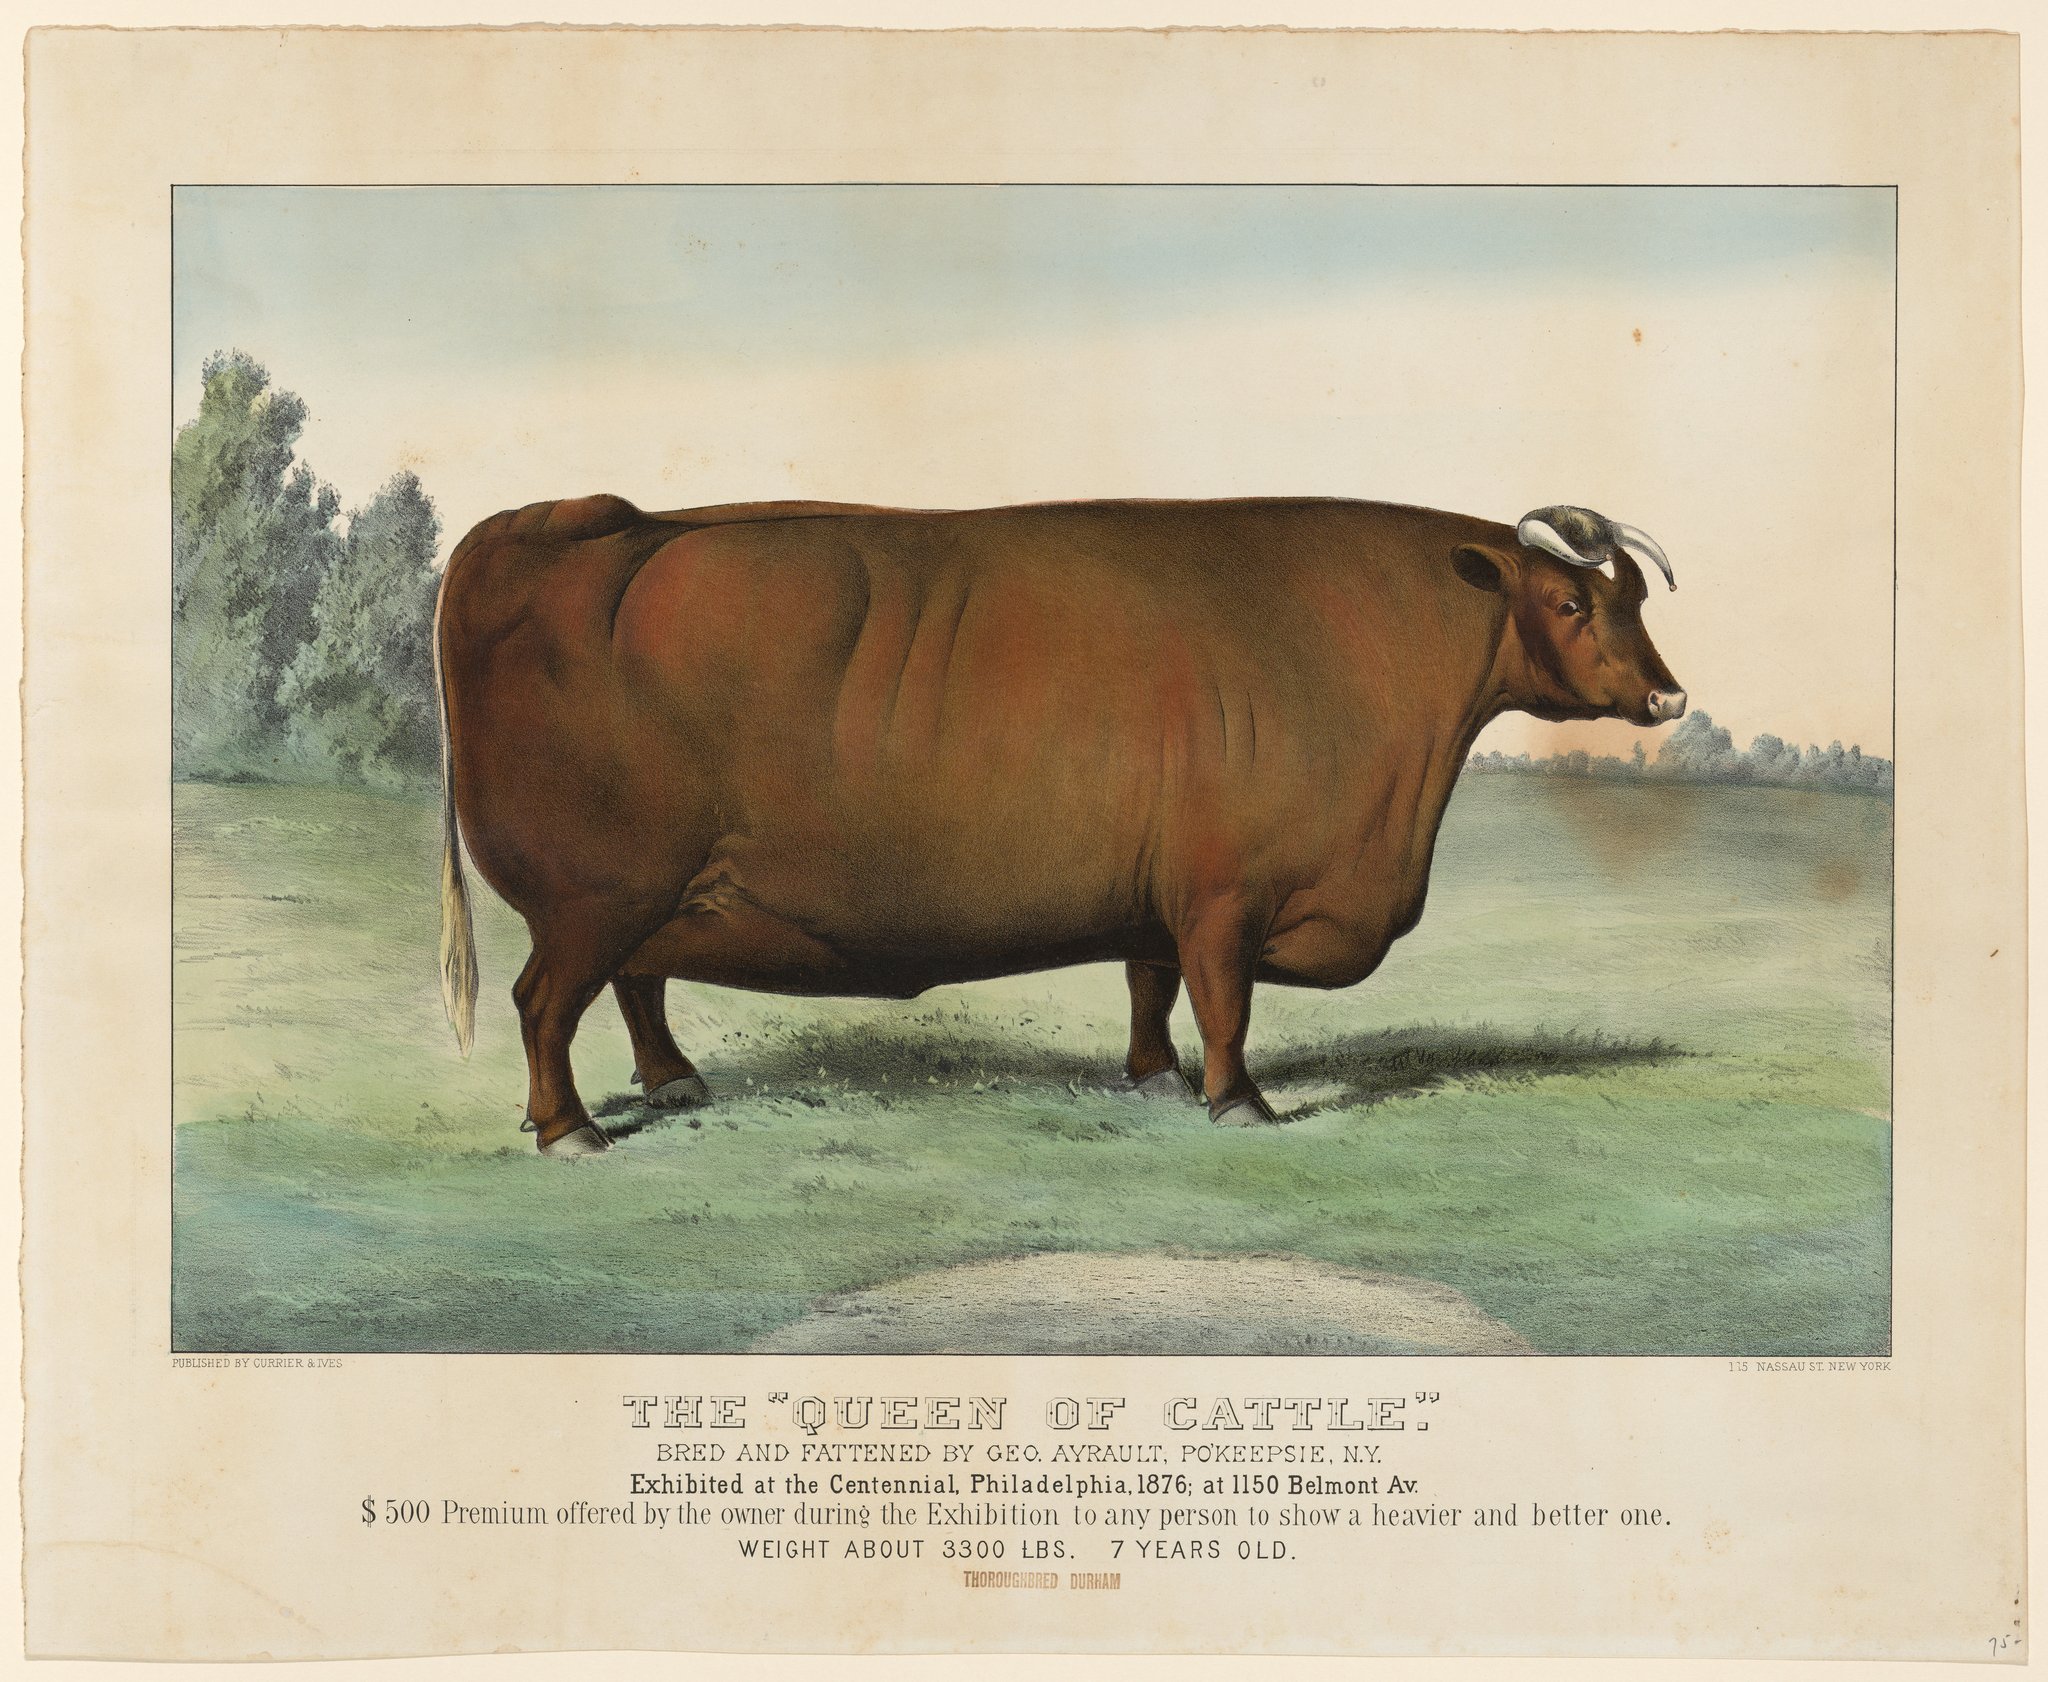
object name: print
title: The "Queen of Cattle" Bred and Fattened by George Ayrault, Poughkeepsie, New York, Exhibited at the Centennial, Philadelphia, 1876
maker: currier & ives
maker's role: publisher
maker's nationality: american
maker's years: 1857-1907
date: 1876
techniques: hand coloring, lithograph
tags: cows